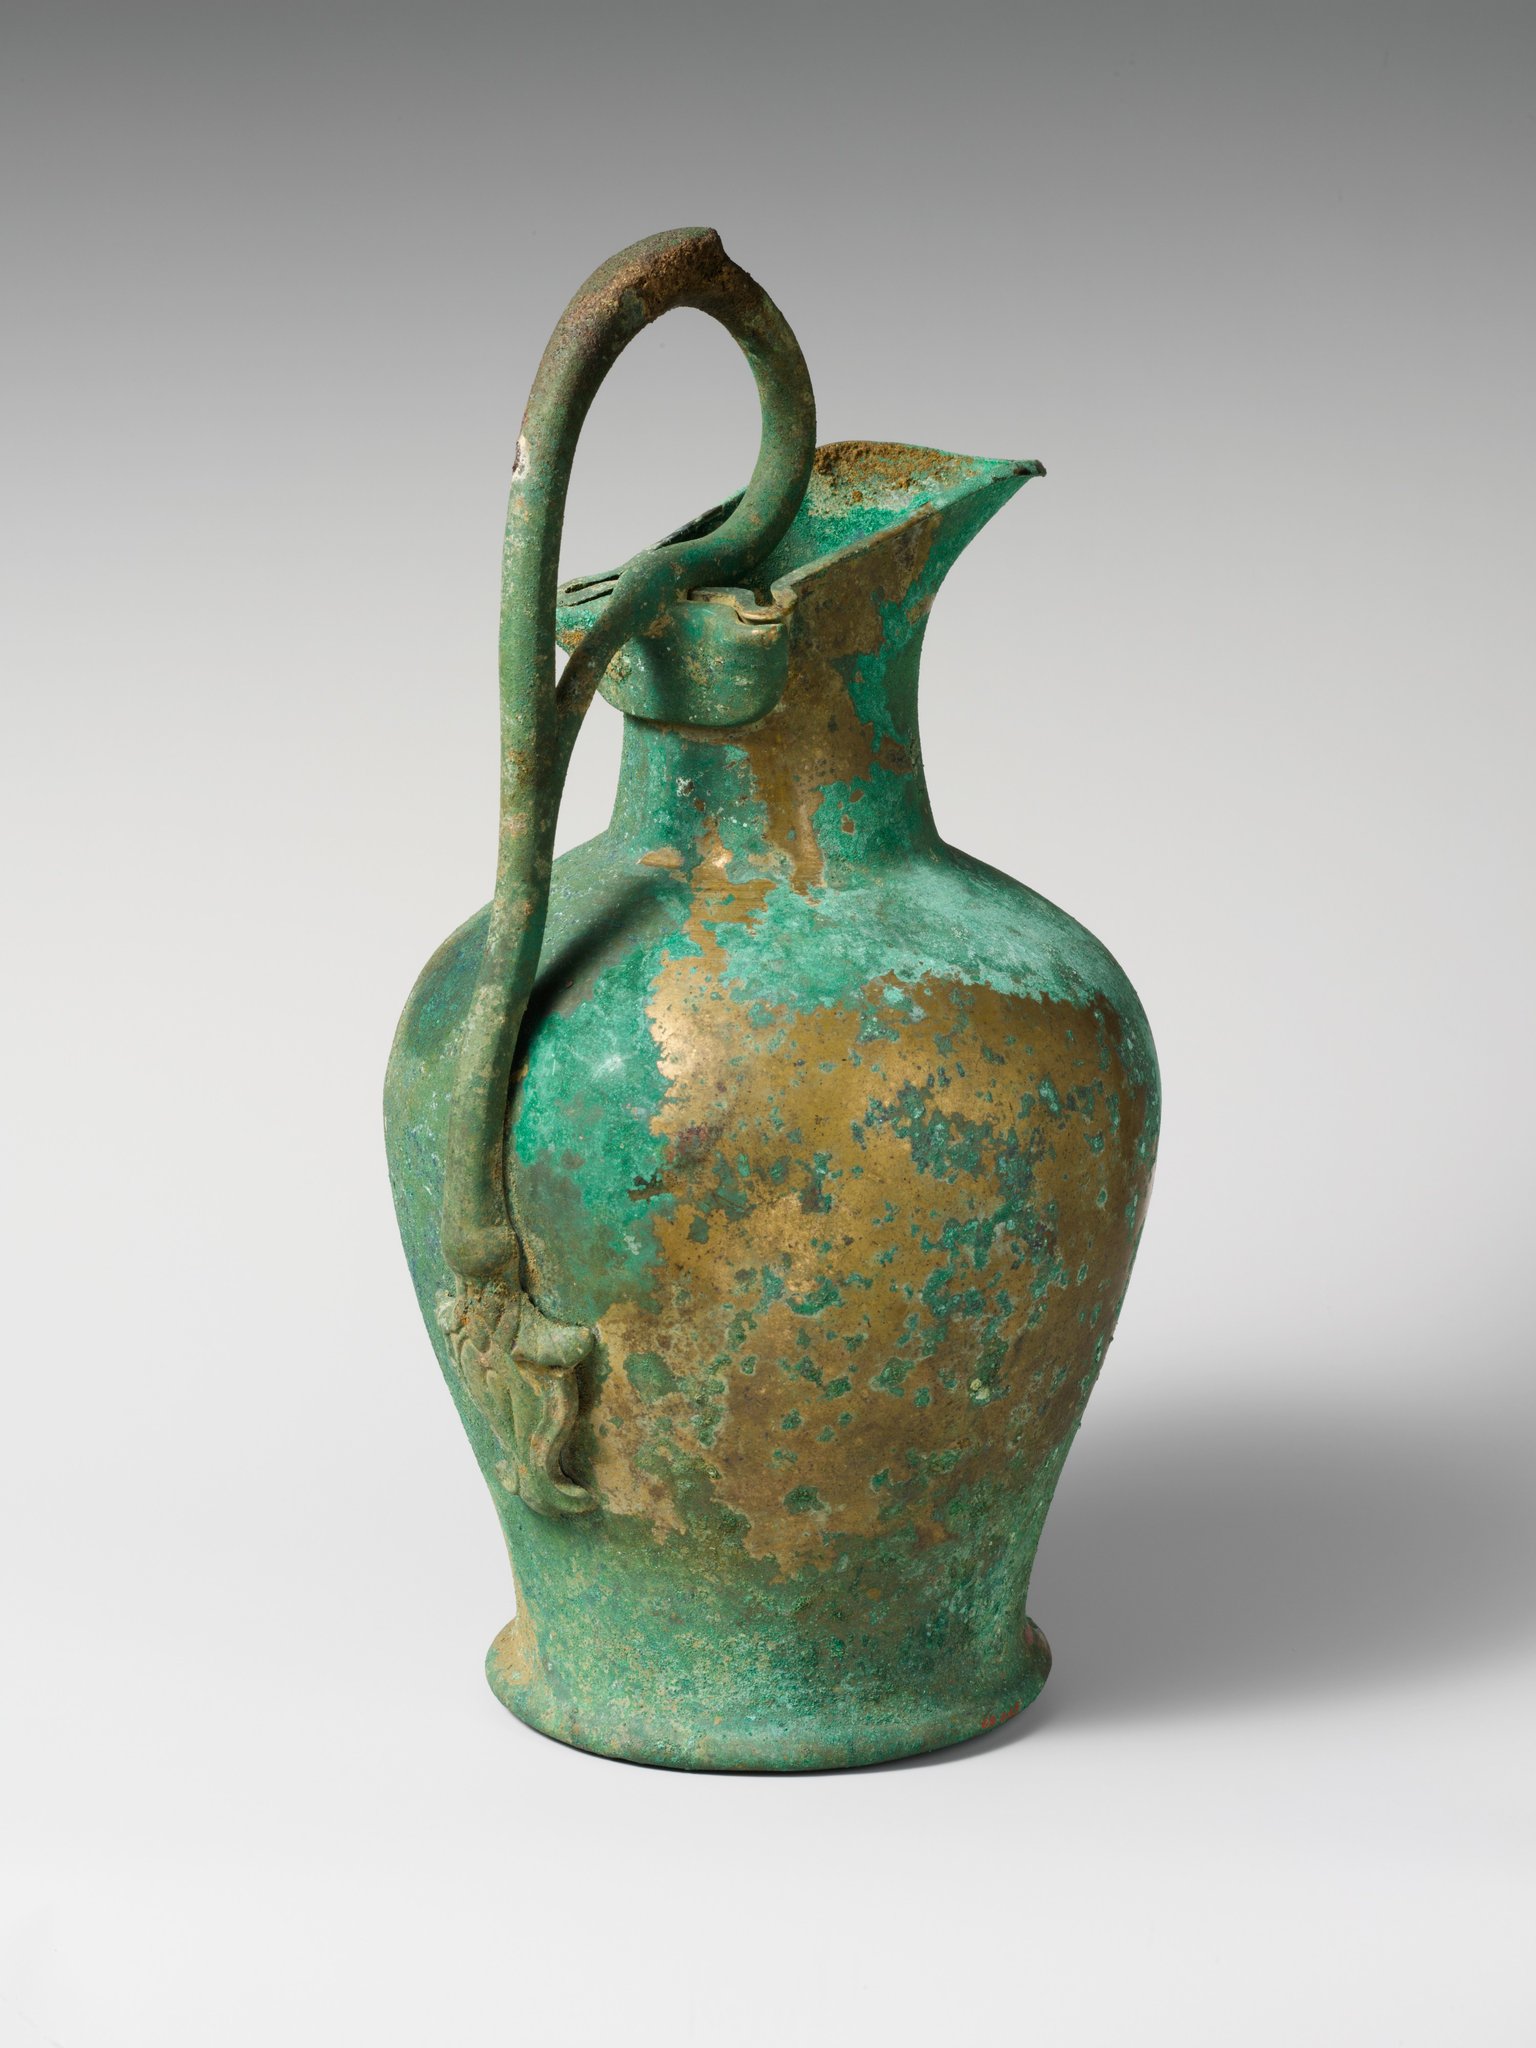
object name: jug with etruscan inscription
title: Bronze oinochoe (jug)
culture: etruscan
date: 300-268 BCE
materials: bronze